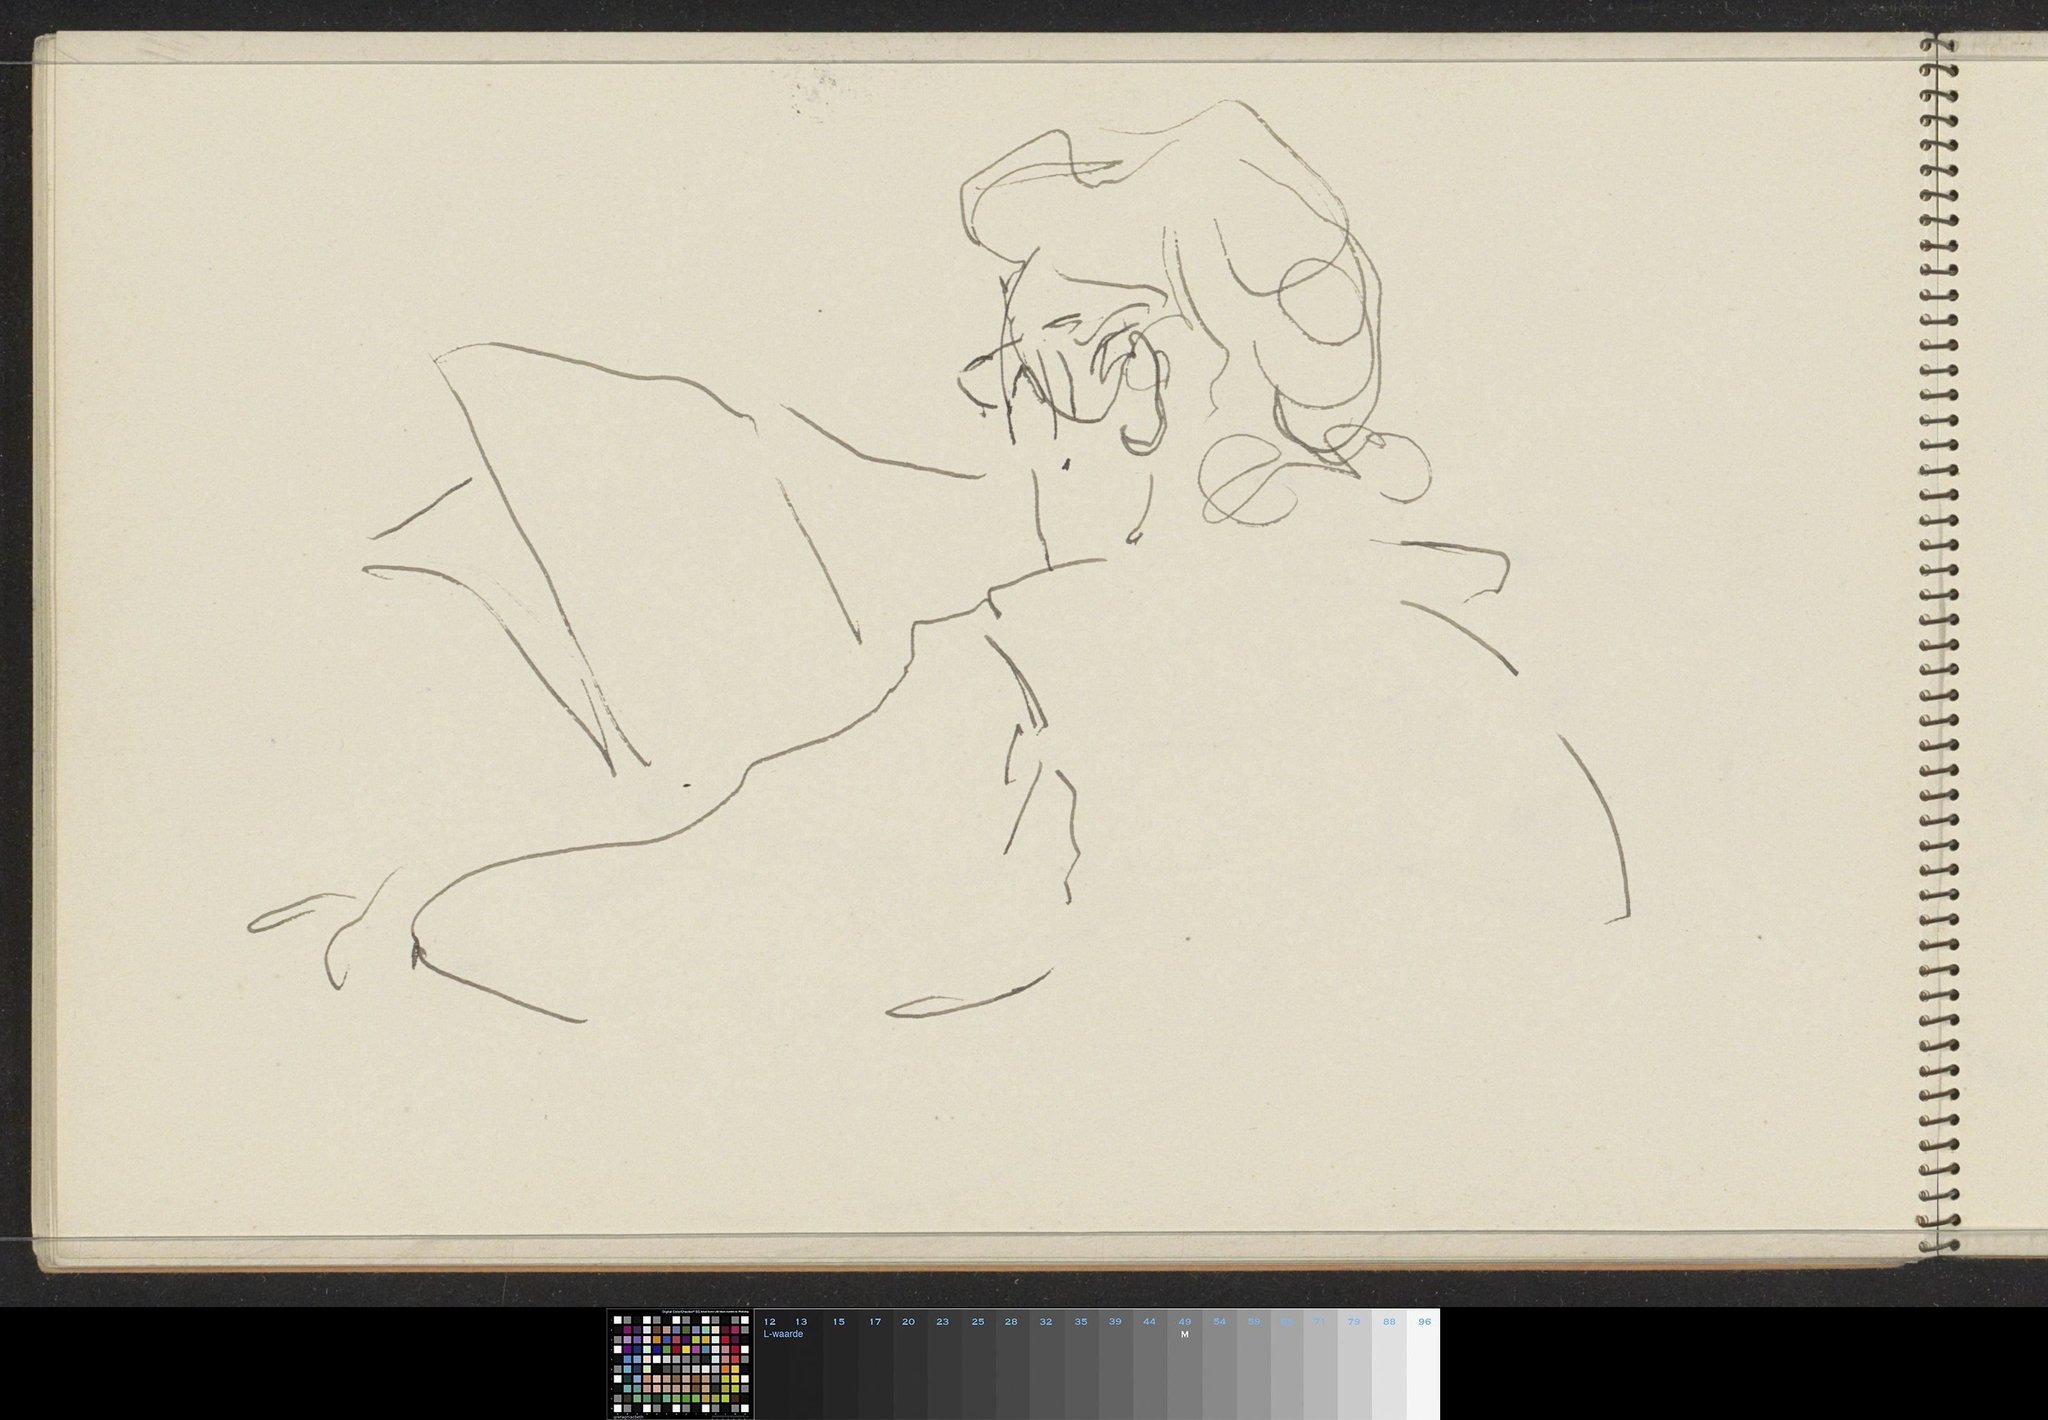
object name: sketchbook leaf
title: Lezende Joanna Lion Cachet-Cordes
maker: carel adolph lion cachet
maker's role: draughtsman, print maker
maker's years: 1864-1945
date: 1935-1940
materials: ink, paper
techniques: pen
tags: adult woman, reading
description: Blad 16 verso uit een schetsboek met 25 bladen.